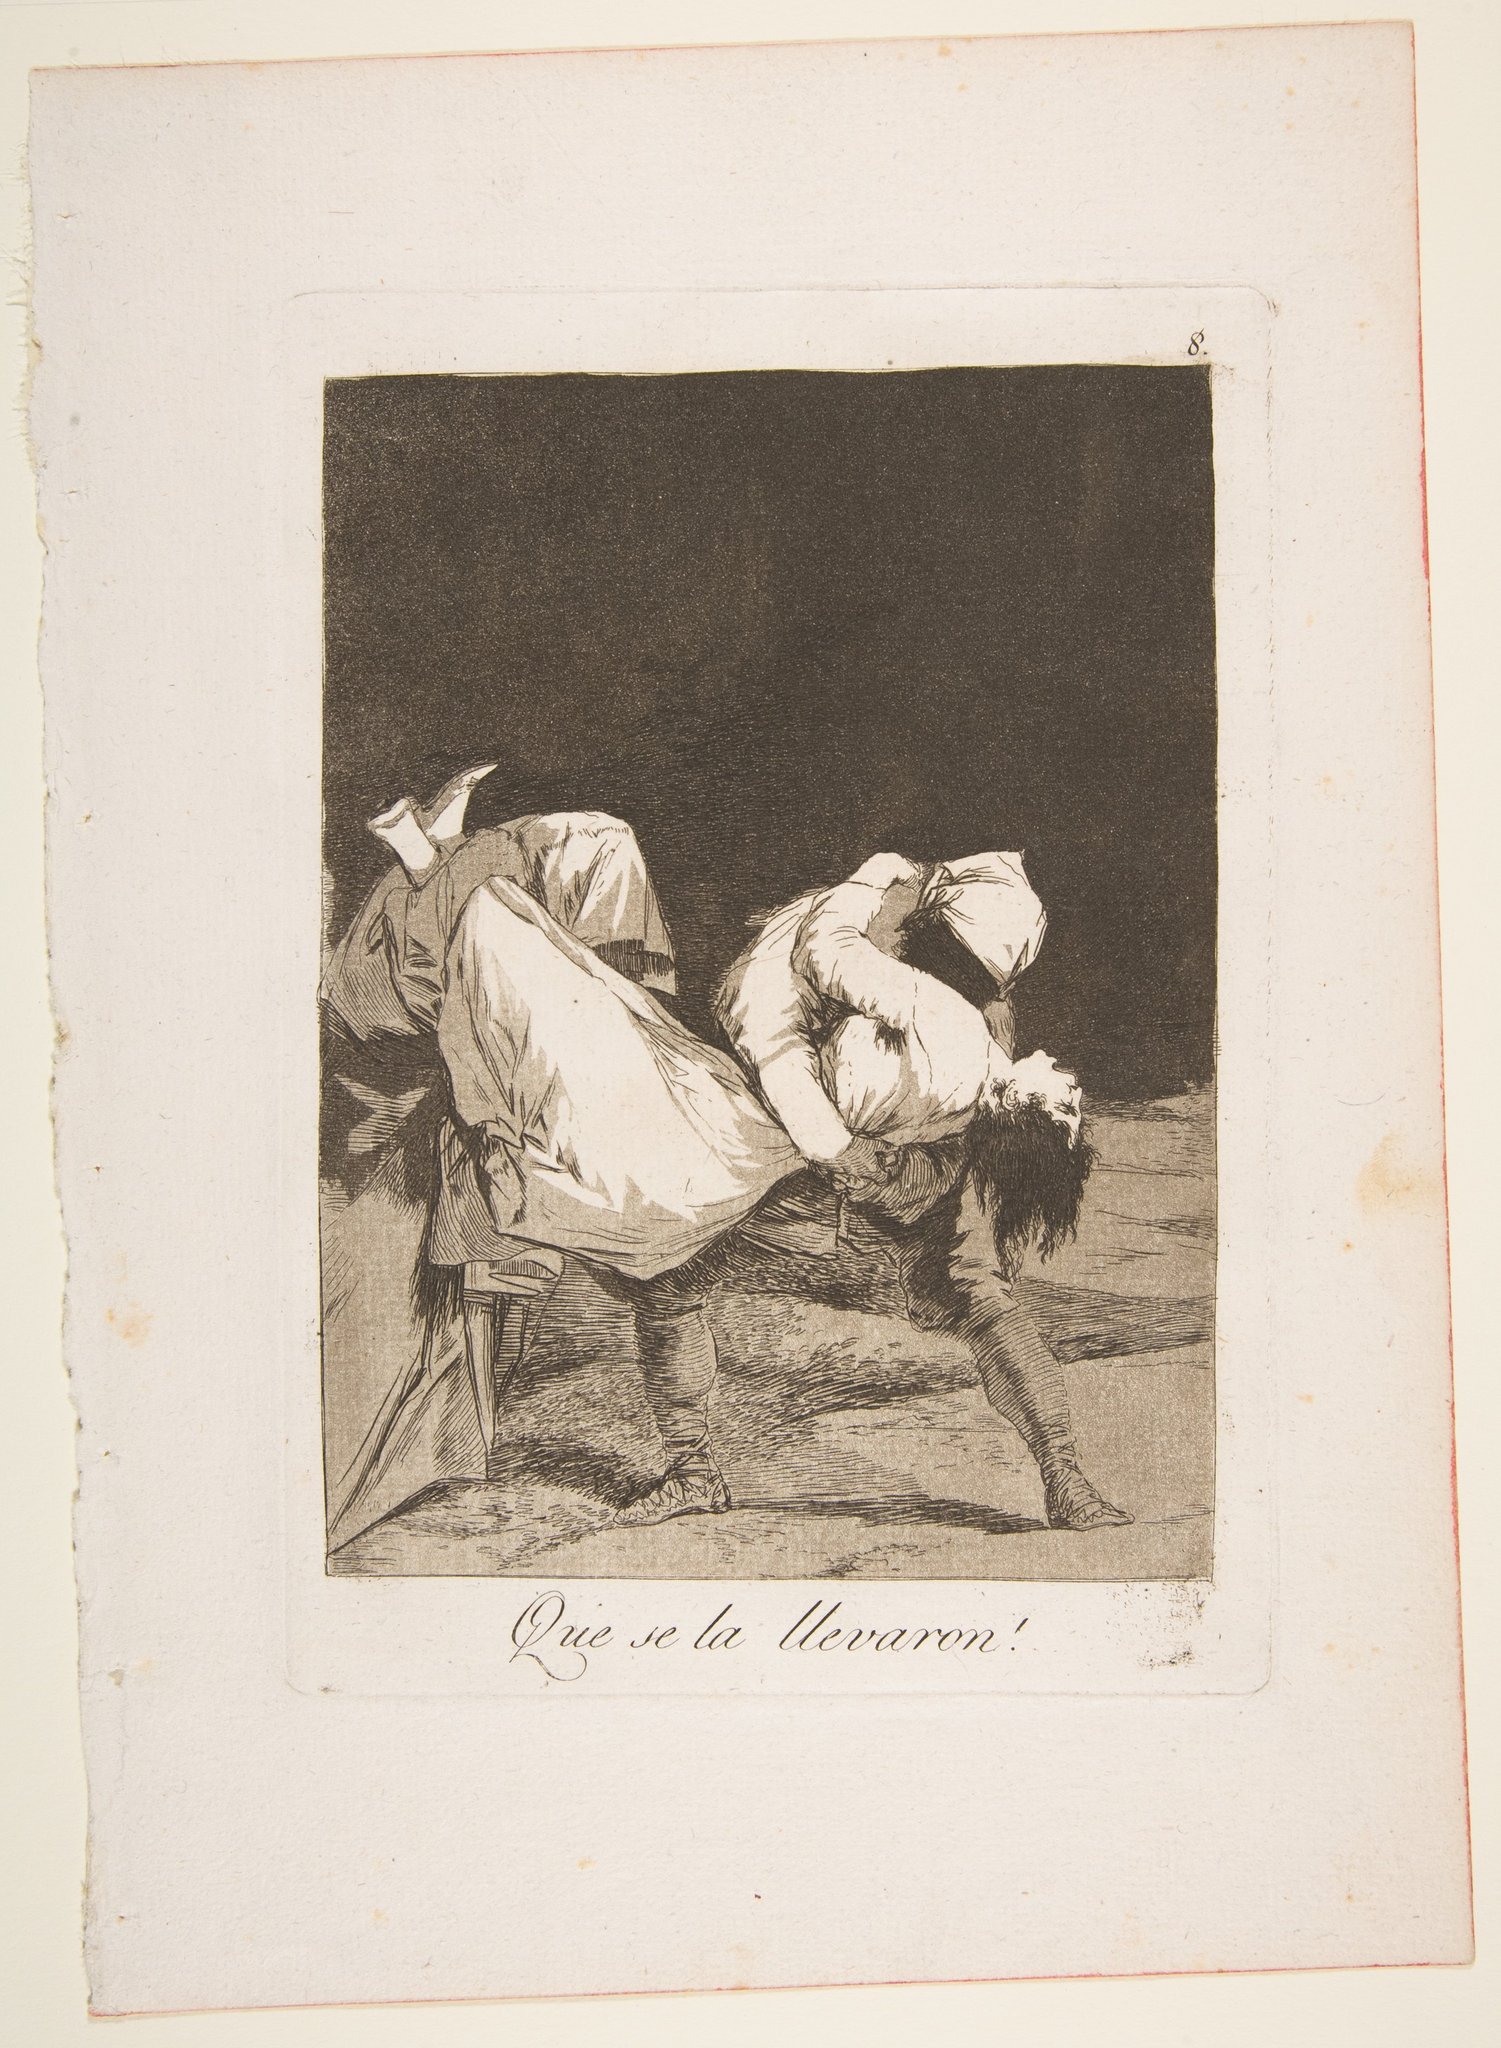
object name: print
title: Plate 8 from "Los Caprichos": They carried her off! (Que se la llevaron!)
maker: goya (francisco de goya y lucientes)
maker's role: artist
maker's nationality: spanish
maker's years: 1746-1828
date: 1799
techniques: aquatint, burnishing, etching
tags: men,women